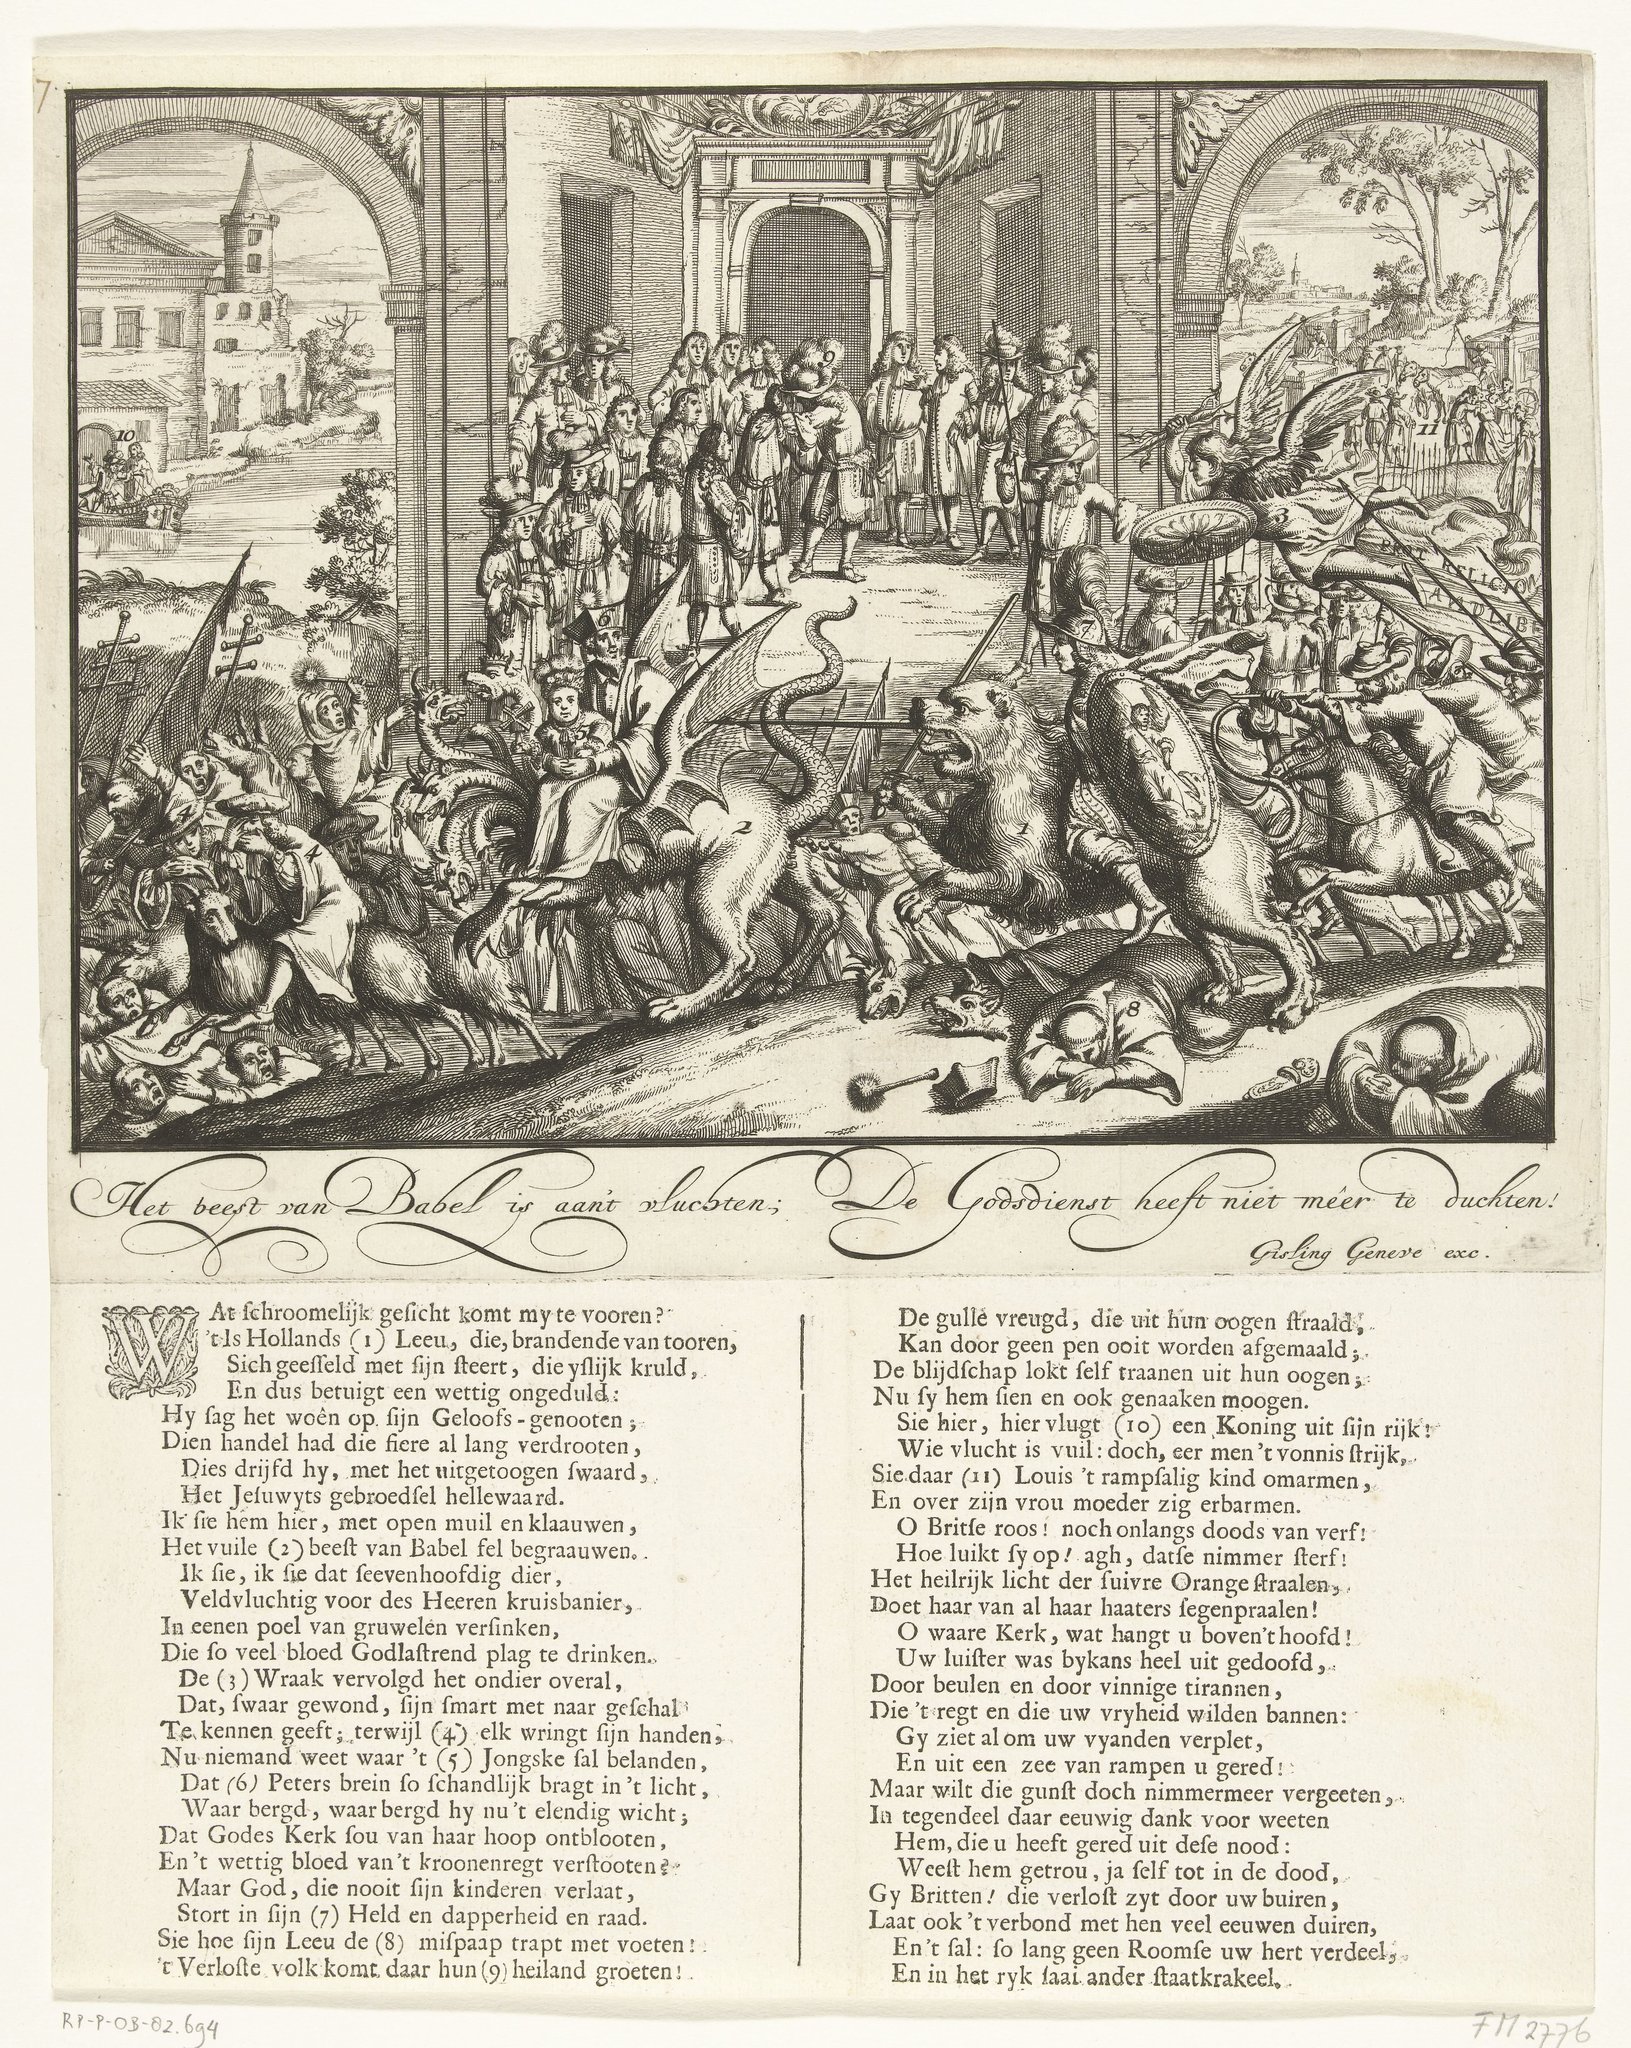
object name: cartoon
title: Willem III op de Hollandse Leeuw verjaagt pater Peters op de draak van Babylon, 1689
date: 1689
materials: paper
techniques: etching, letterpress printing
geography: northern netherlands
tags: jacobus ii (koning van engeland en schotland), the hague, william iii (prince of orange and king of england, scotland, and ireland), lodewijk xiv (koning van frankrijk), rome, the scarlet woman, the whore of babylon; she is usually sitting on a scarlet beast with seven heads and ten horns, political caricatures and satires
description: Prins Willem III als held op de Hollandse Leeuw verjaagt pater Peters met het molenaarskind zittend als de hoer van Babylon op het beest samen met alle andere katholieken, 1689. Midden achter wordt Willem verwelkomd door de Engelsen, op de achtergrond links en rechts het vluchten van koning Jacobus II uit Londen en zijn aankomst in Frankrijk bij Lodewijk XIV. Op het blad onder de plaat een vers in twee kolommen.